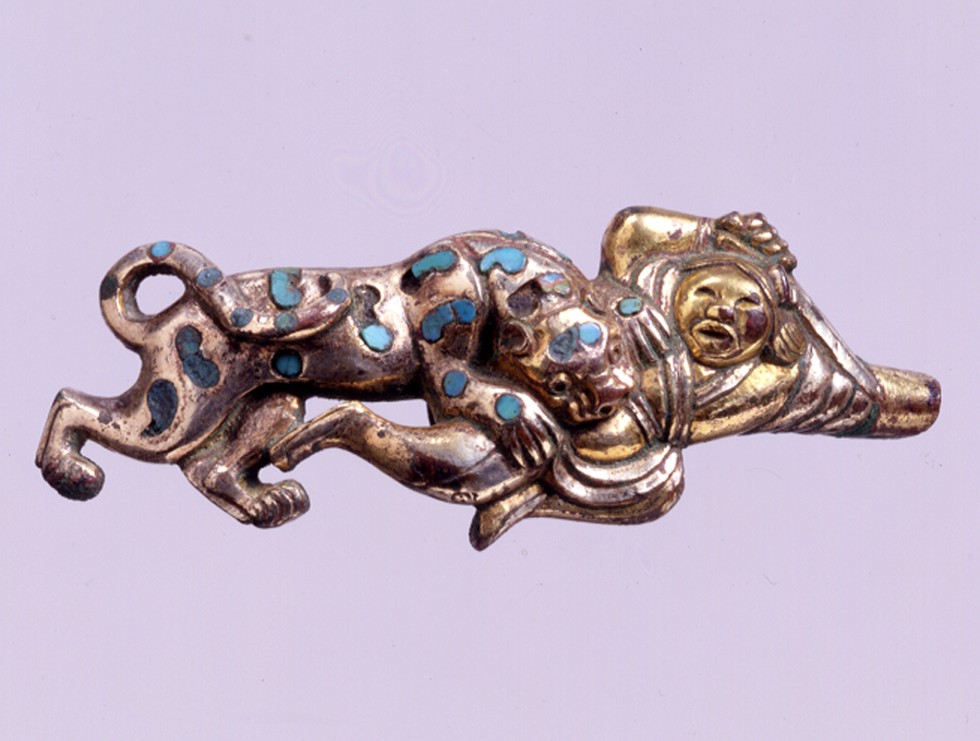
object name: belt hook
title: Belt Hook in the Shape of a Warrior and a Leopard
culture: north chinese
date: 300-1 BCE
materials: gilt bronze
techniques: inlay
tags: men,leopards